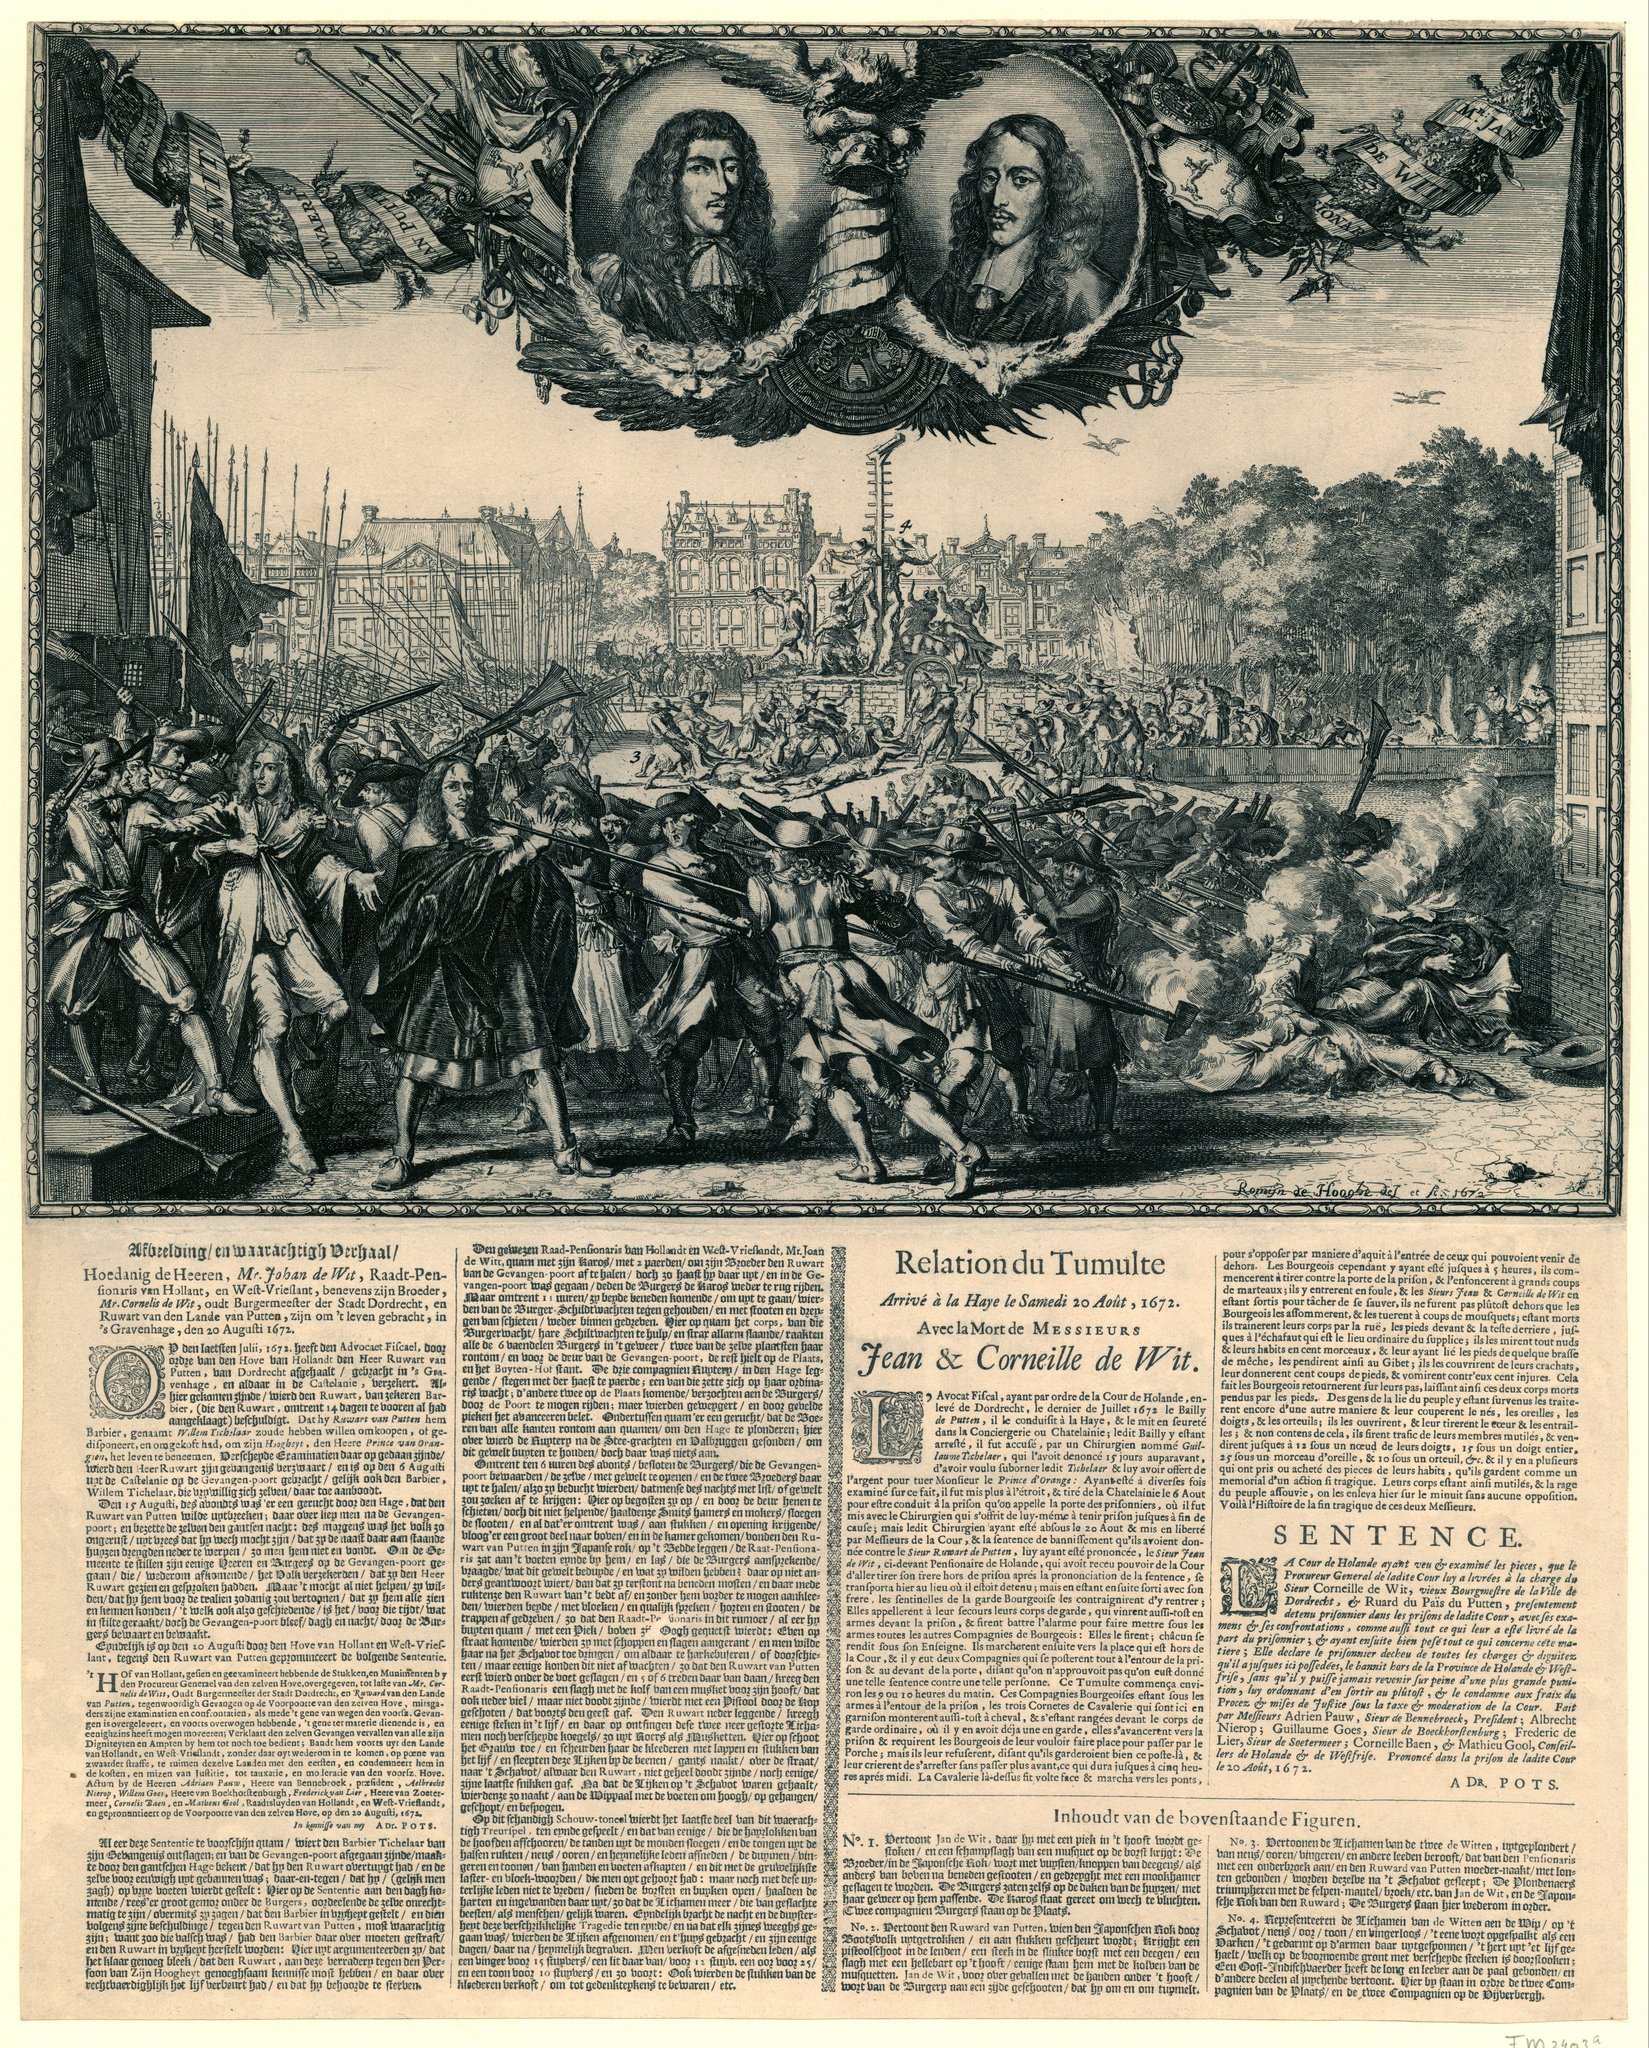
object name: print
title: Afbeelding en waarachtigh Verhaal Hoedanigh de Heeren, Mr. Johan de Witt, Raadt-Pensionaris van Hollant, en West-Vrieslant, benevens zijn Broeder, Mr. Cornelis de Wit, oudt Burgermeester der Stadt Dordrecht, en Ruwart van den Lande van Putten, zijn om't leven gebracht, in 's Gravenhage, den 20 Augusti 1672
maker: romeyn de hooghe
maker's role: draughtsman, goldsmith, painter, print maker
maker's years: 1645-1708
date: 1672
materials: paper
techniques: engraving, etching, letterpress printing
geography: northern netherlands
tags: dordrecht, cornelis de witt, politician, johan de witt, lynching, attempt, political murder, violent death, being killed; being mishandled and maltreated; seeking death (+ death by lynching), the hague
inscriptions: date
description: Prent waarin de verschillende episodes van de moord op de gebroeders De Witt tot één grote voorstelling zijn verwerkt. Bovenin de voorstelling zijn portretten van Johan en Cornelis de Witt aangebracht. Onderaan staan dezelfde beschrijvingen van de gebeurtenissen in 2 kolommen in het Nederlands en 2 kolommen Frans, en een uitleg van de afbeelding, als in FM 2401a.